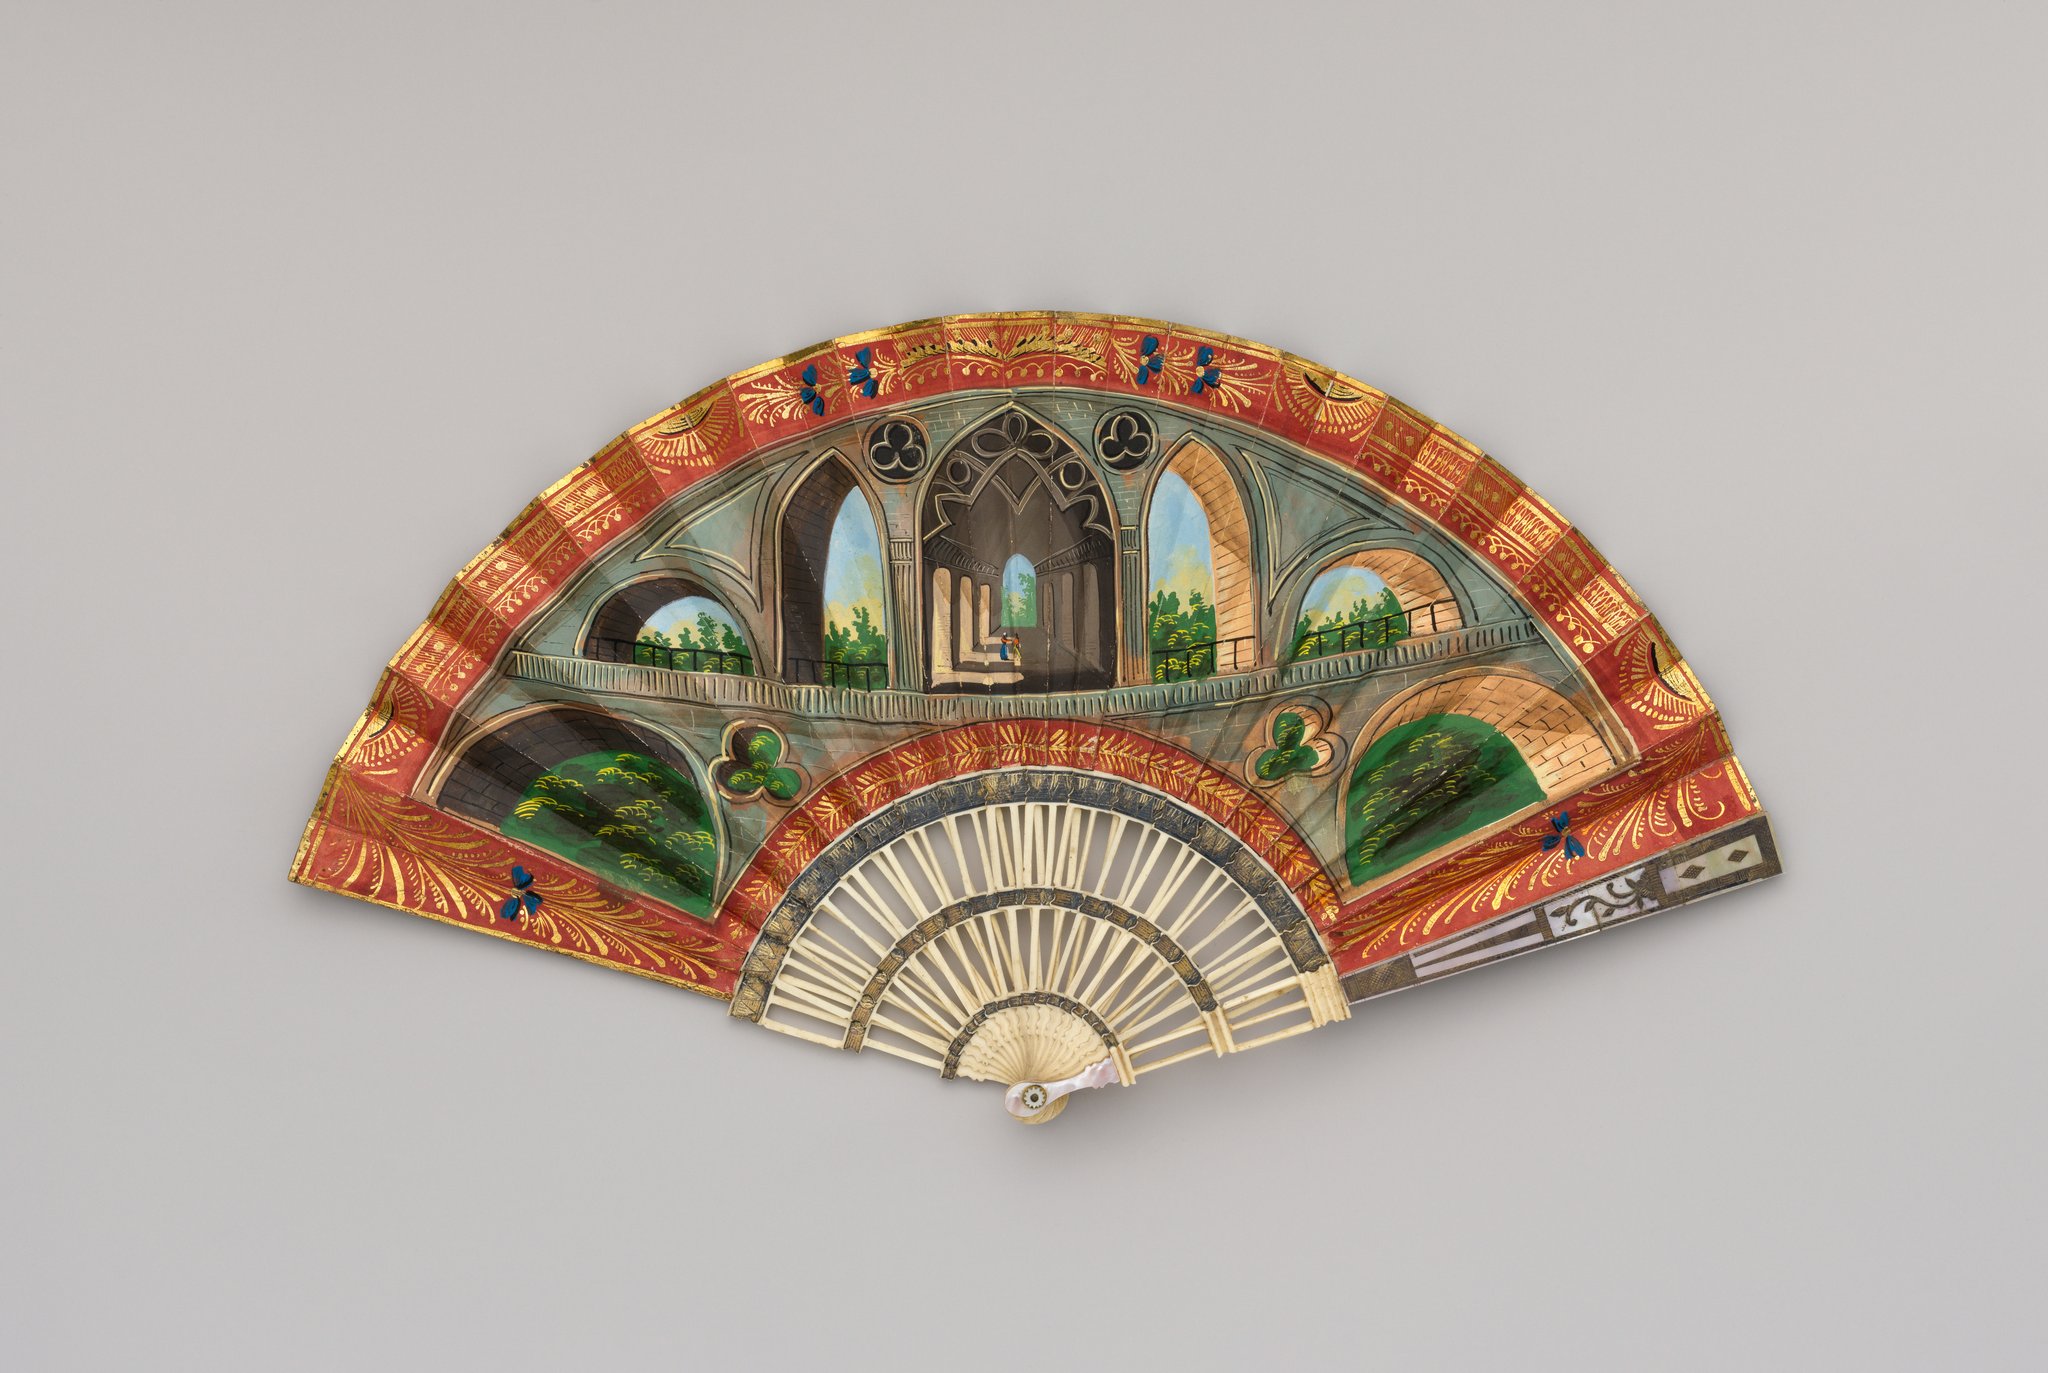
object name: fan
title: Folding Fan with Representation of a Gothic Revival Arcade, perhaps a Souvenir of Stowe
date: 1820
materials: gilt, ivory, paint, paper